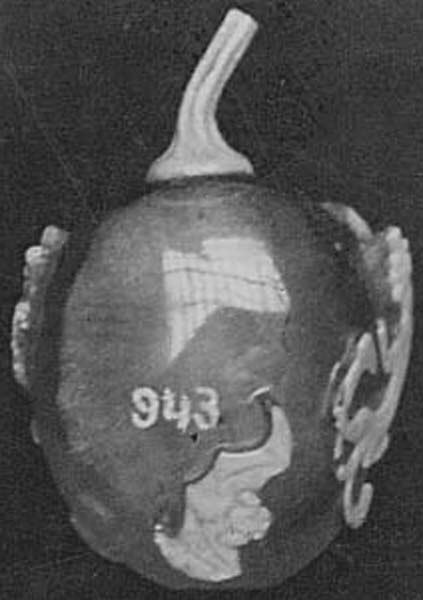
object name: snuff bottle with stopper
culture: chinese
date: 1701-1900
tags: bats